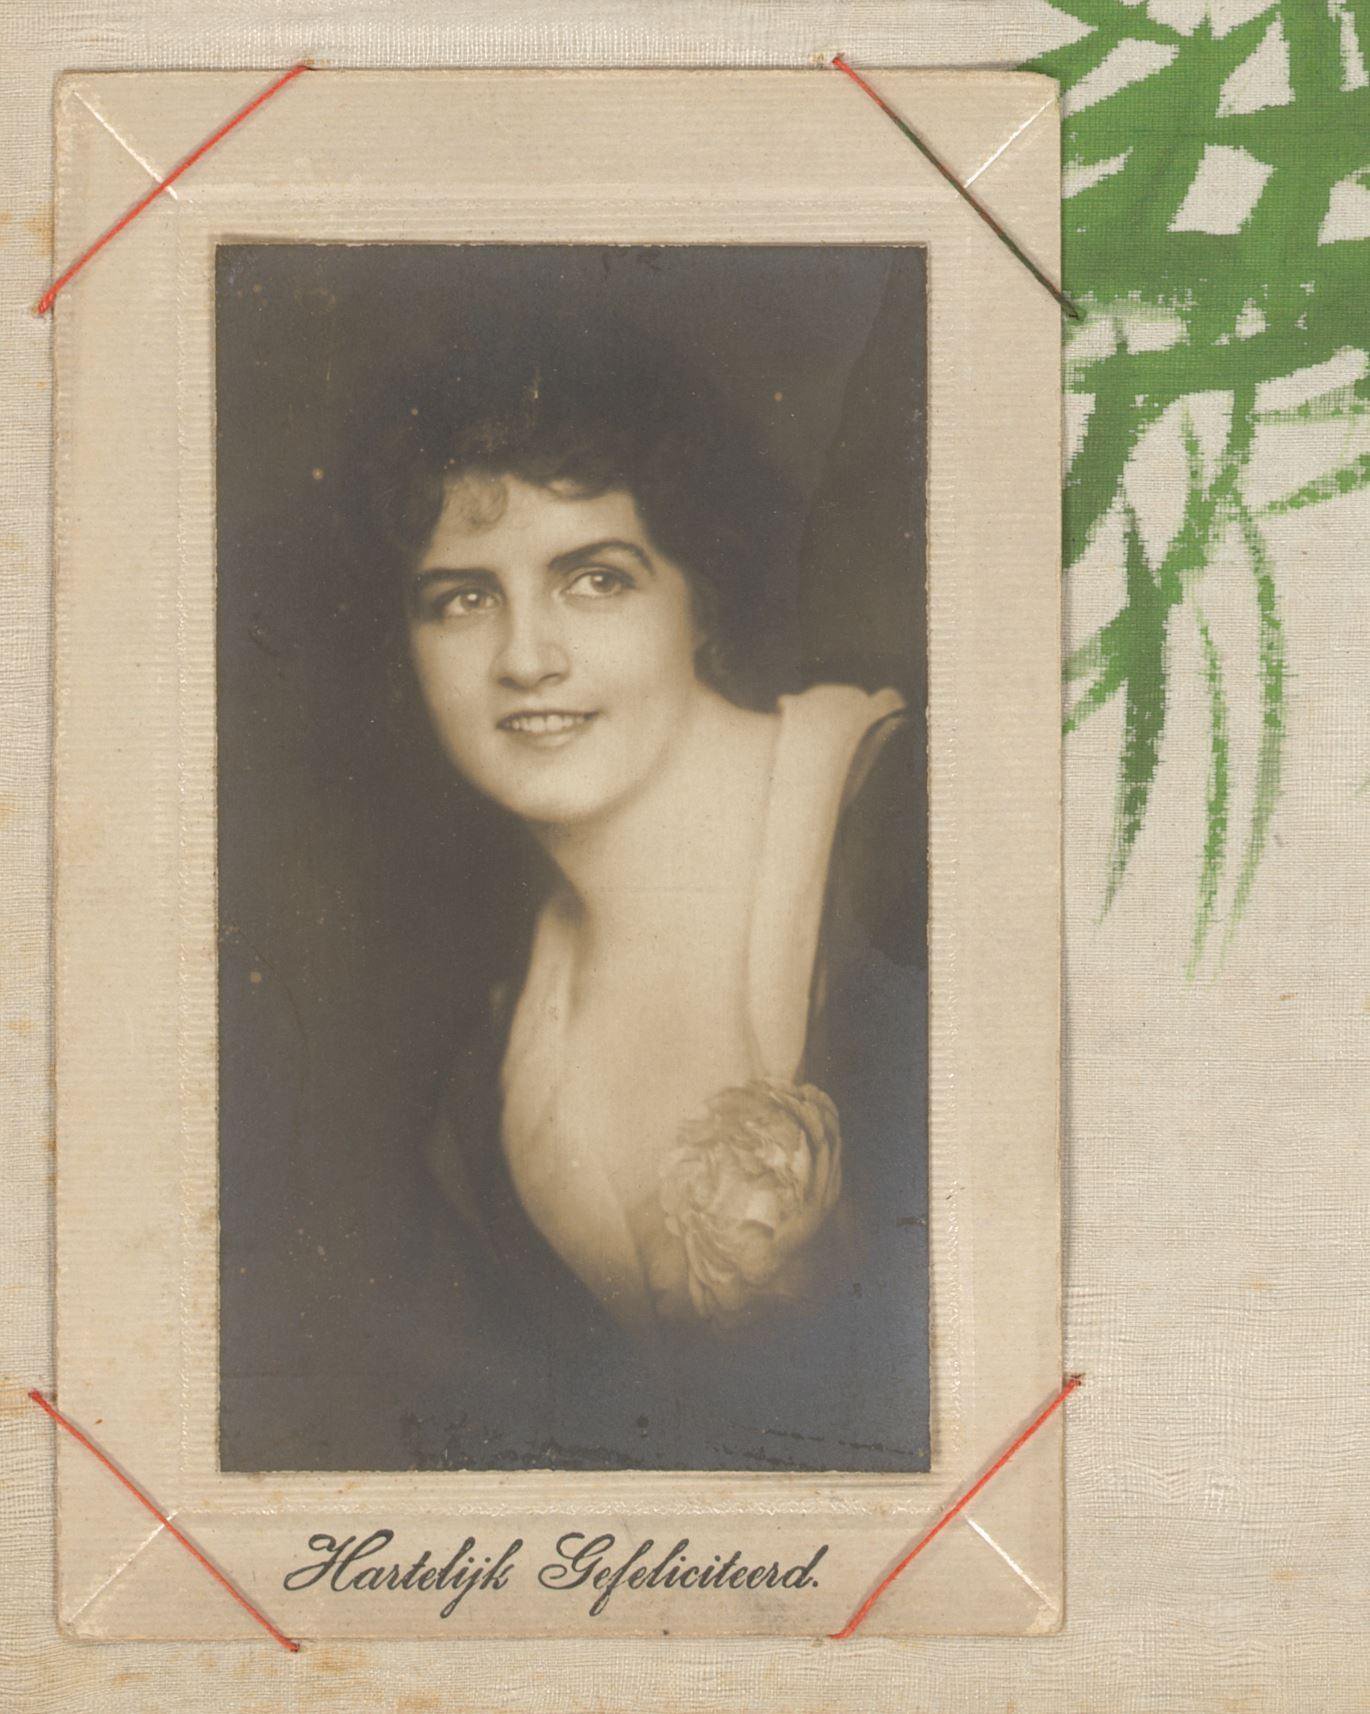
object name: album leaf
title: Hartelijk Gefeliciteerd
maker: Anonymous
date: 1880-1920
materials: paint, photographic support, silk, textile, watercolor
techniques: brush, gelatin silver print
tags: flowers, adult woman, historical persons